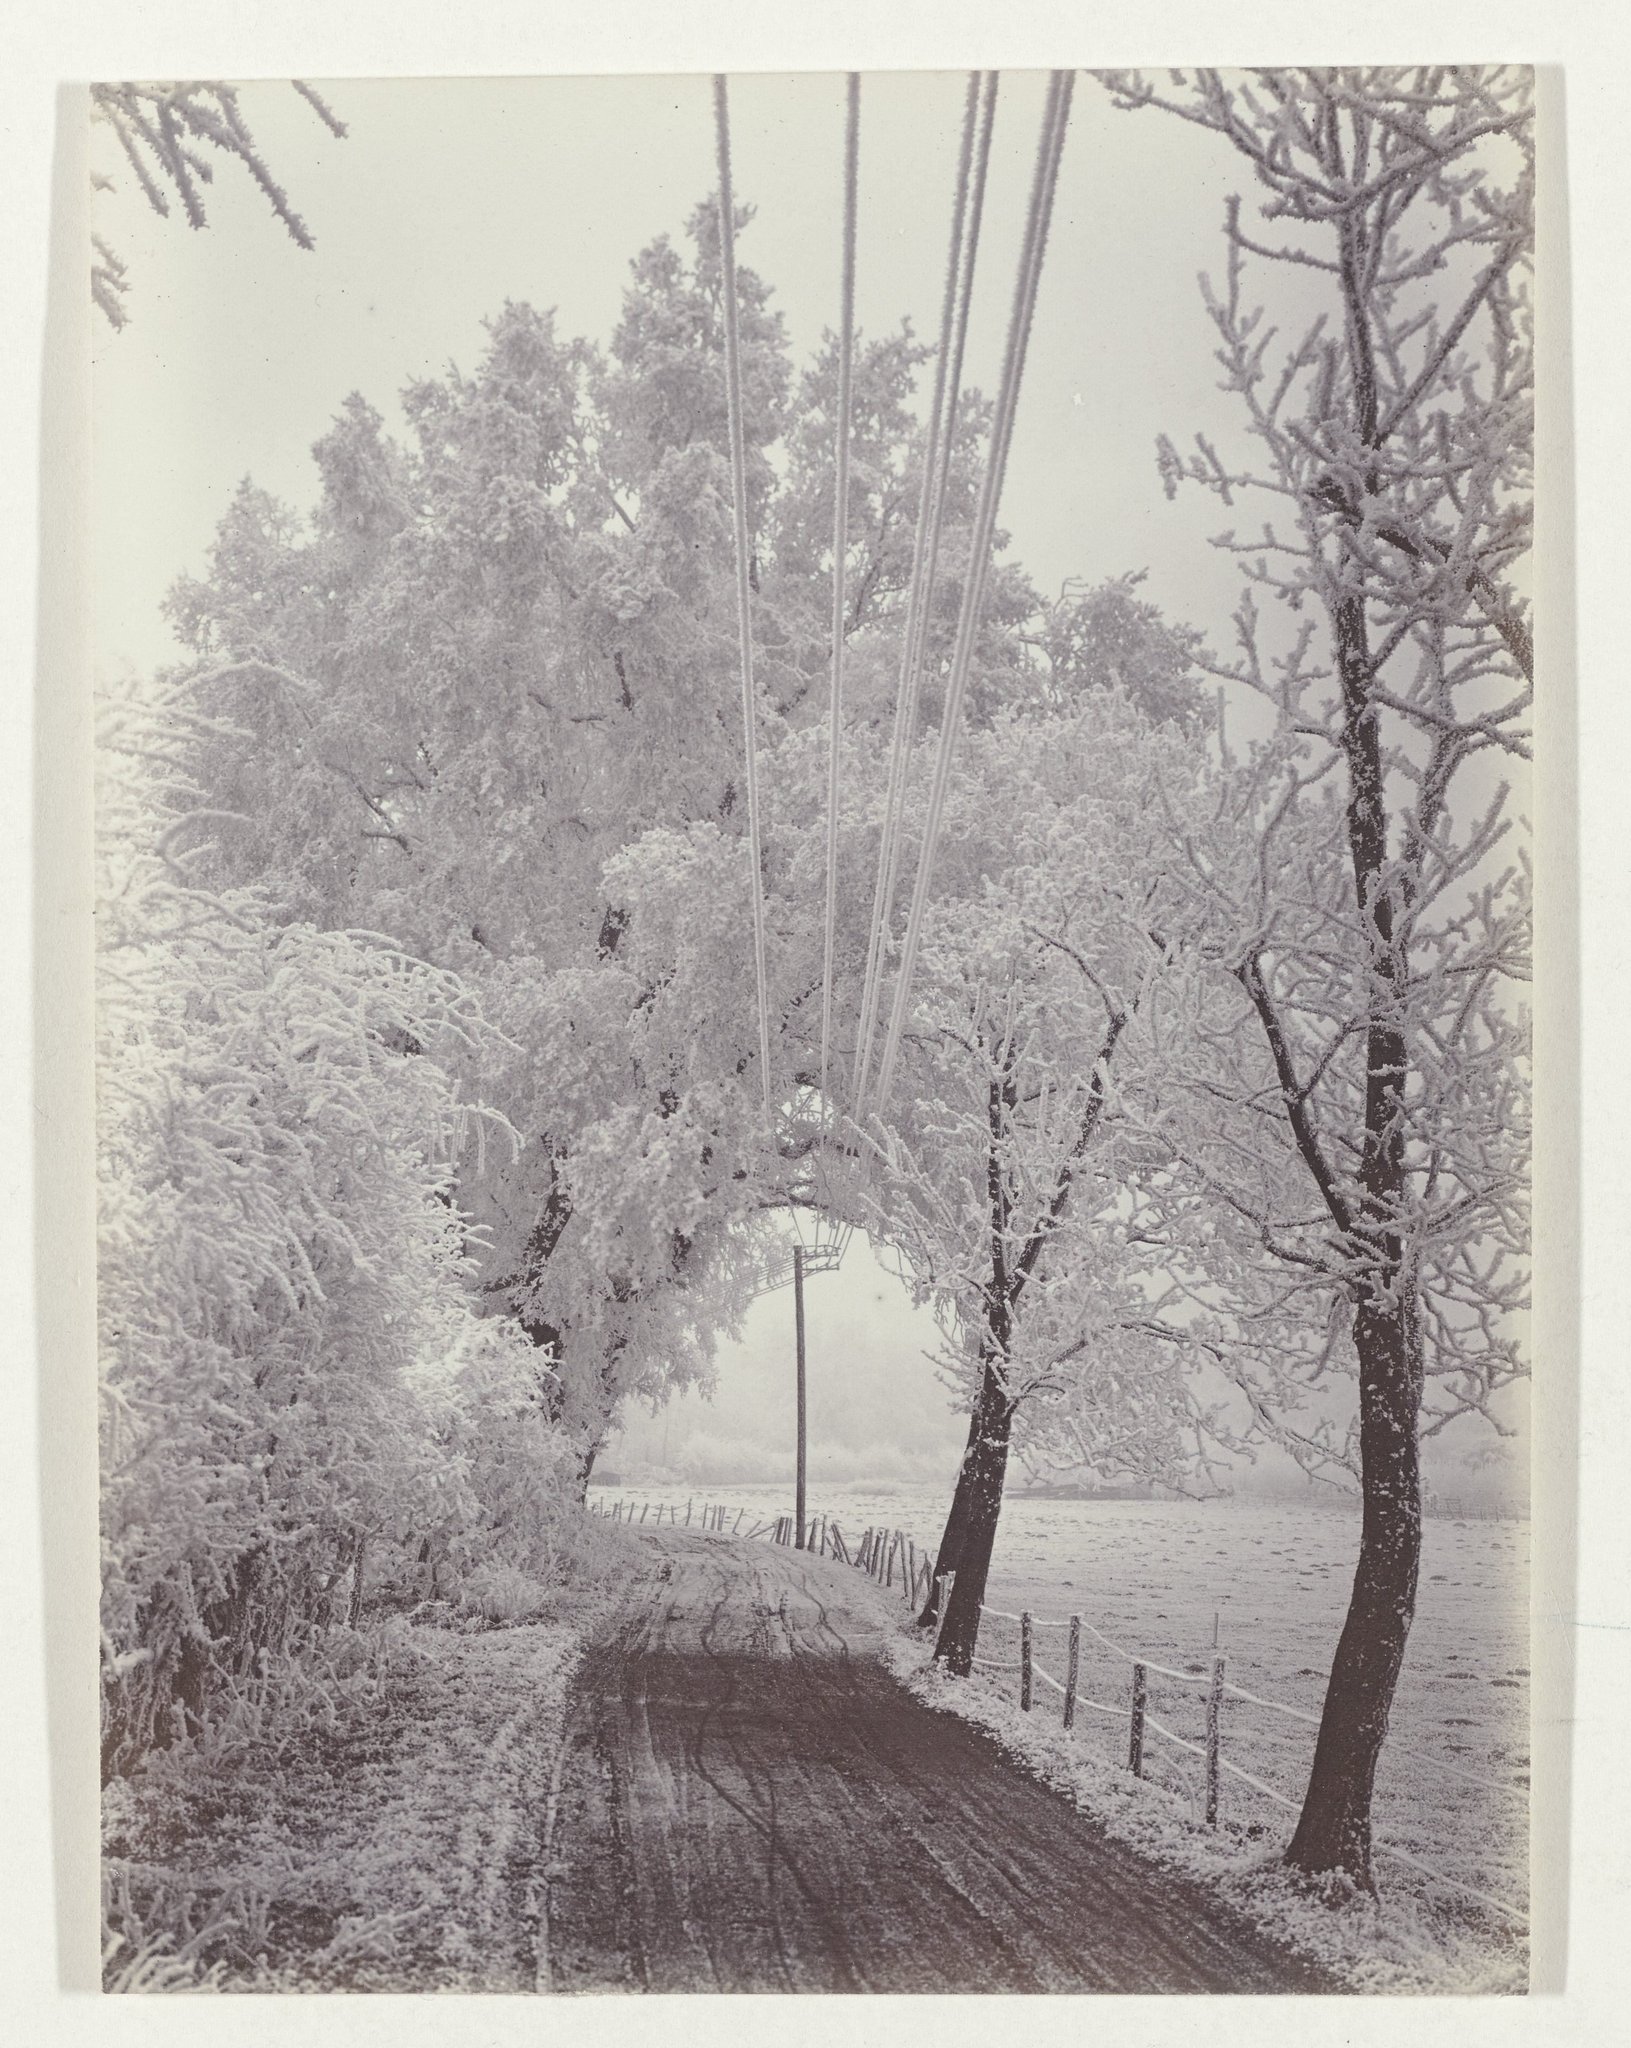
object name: photograph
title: Winterlandschap langs de Aelbertsbergweg in Bloemendaal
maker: richard tepe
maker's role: fotograaf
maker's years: 1864-1952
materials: photographic support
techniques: salted paper print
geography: bloemendaal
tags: landscapes, snow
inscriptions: number: ‘II’